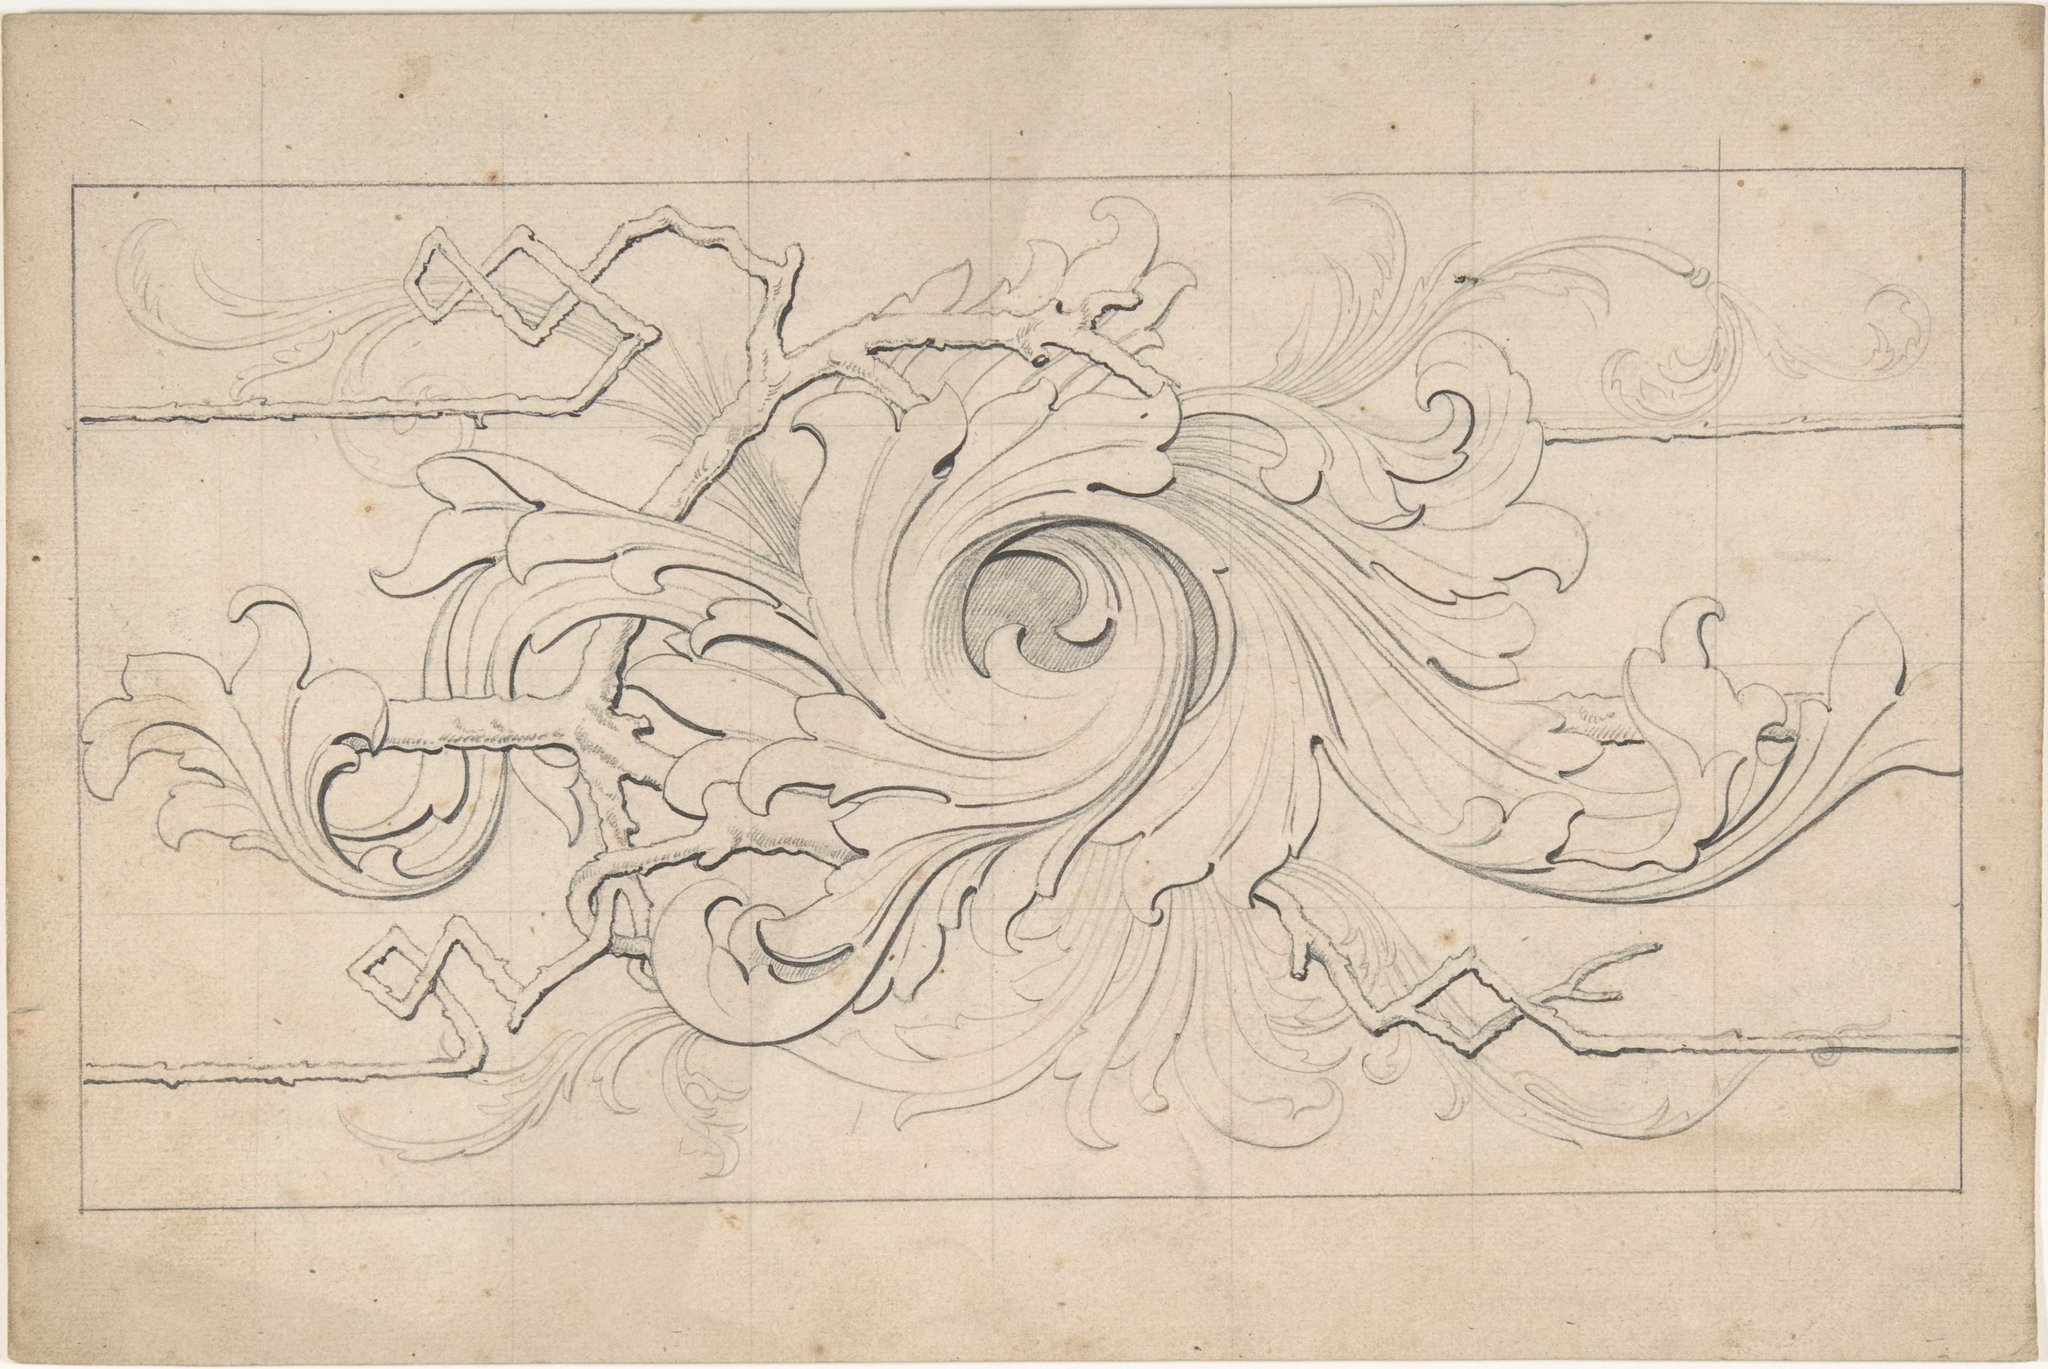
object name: drawing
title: Designs for borders and corners, acanthus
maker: robert william hume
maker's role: artist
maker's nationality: british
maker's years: 1816-1904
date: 1830-1904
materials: graphite, ink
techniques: pen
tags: ornament